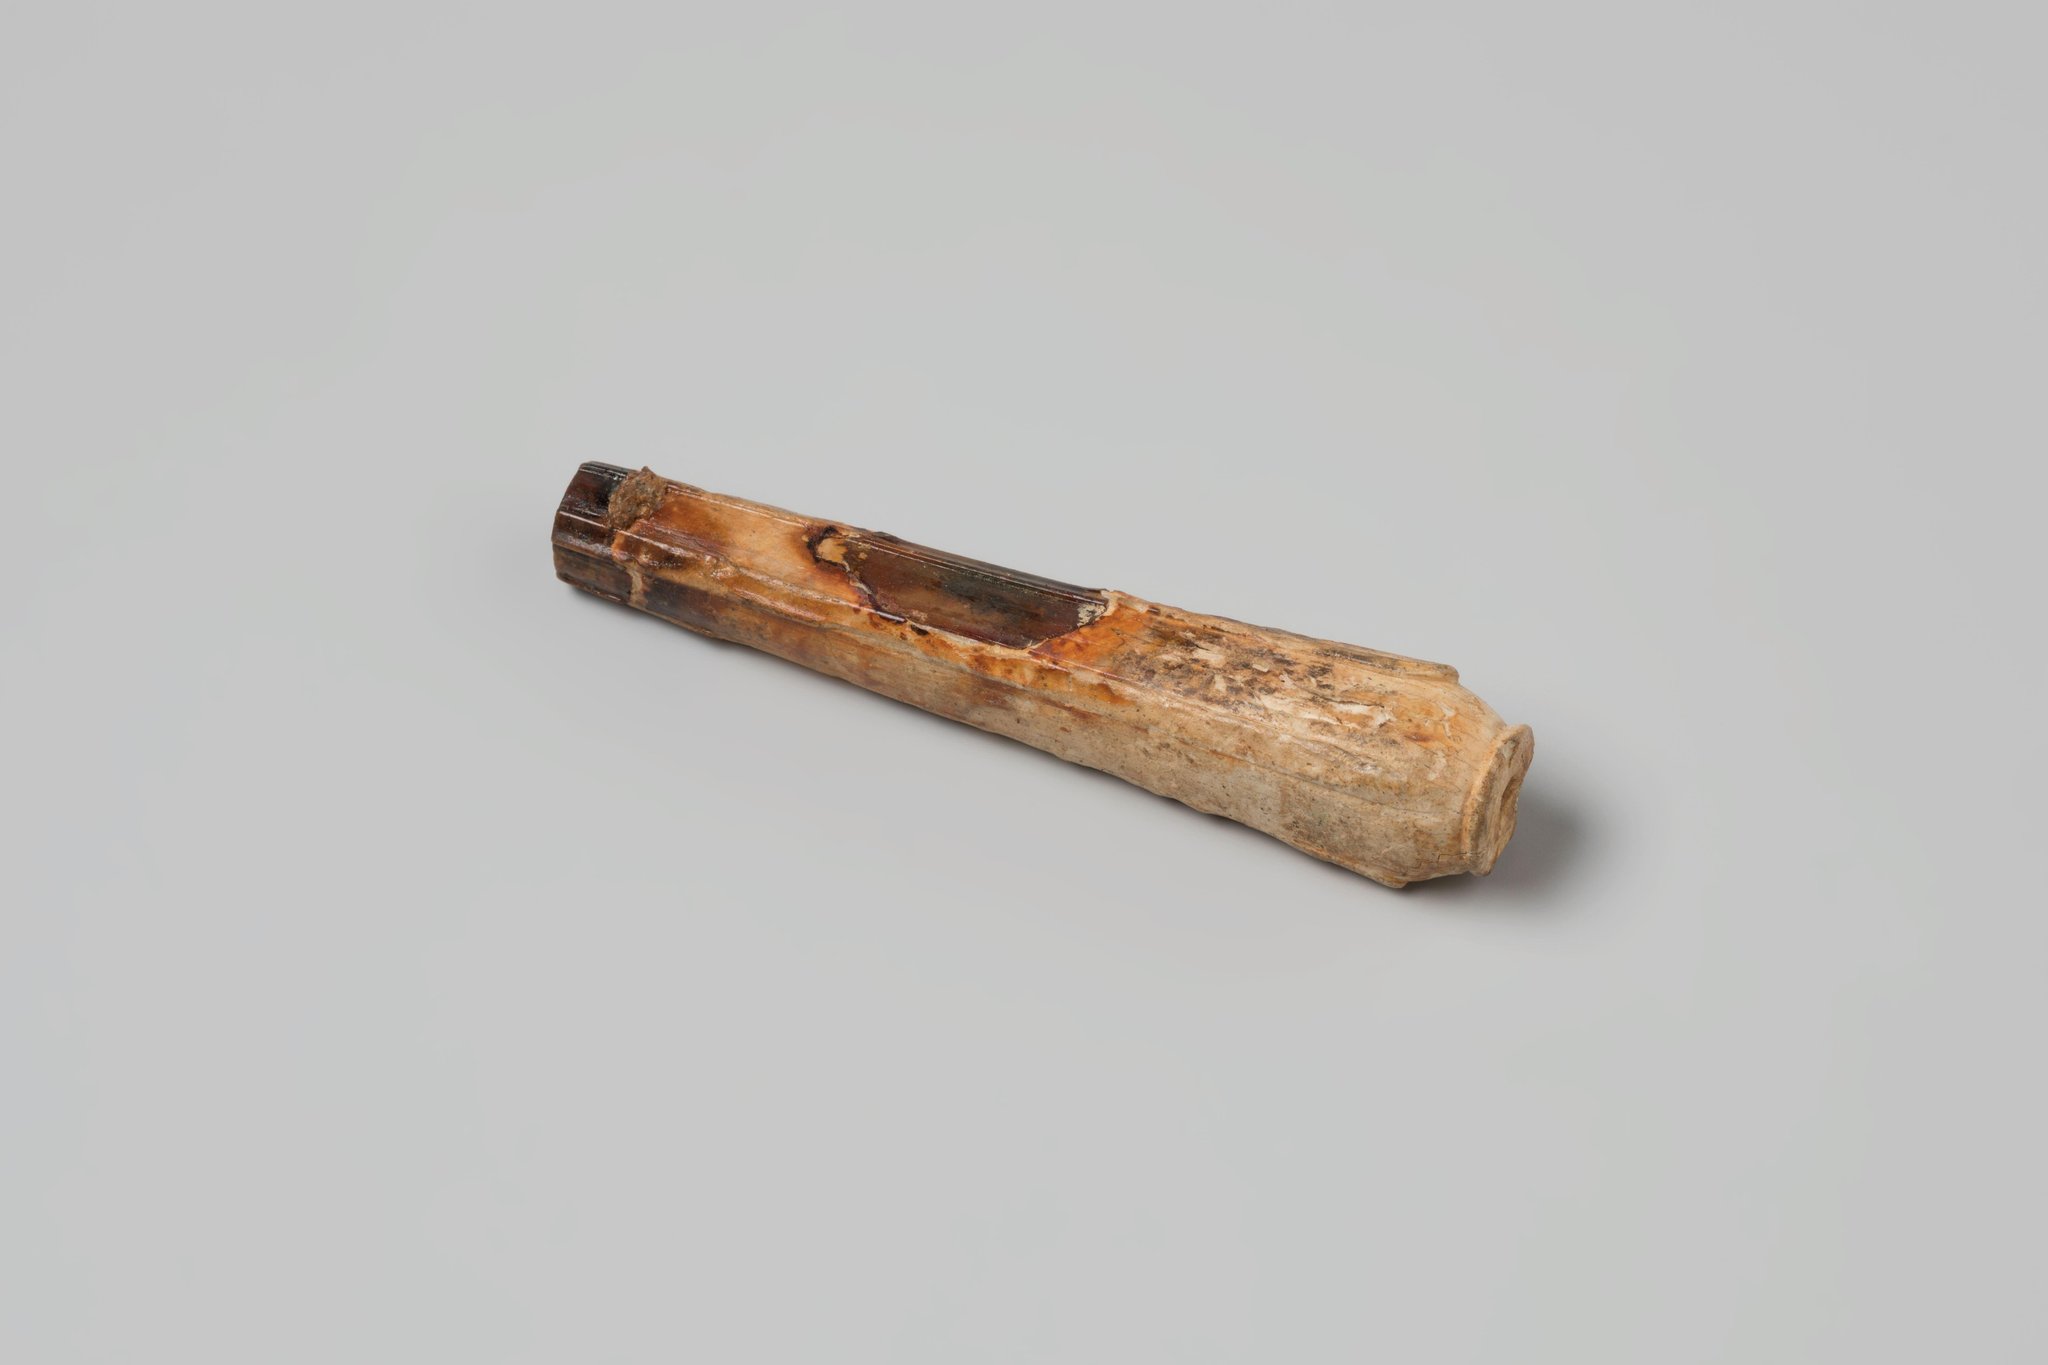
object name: knife handle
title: Messenheft uit het wrak van de Oost-Indiëvaarder Hollandia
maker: Anonymous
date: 1700-1743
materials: bone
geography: netherlands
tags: verenigde oostindische compagnie, hollandia (schip), annet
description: Knife-handle, straight-sided: tapering; square in section, edges ribbed, circular flat upper end.